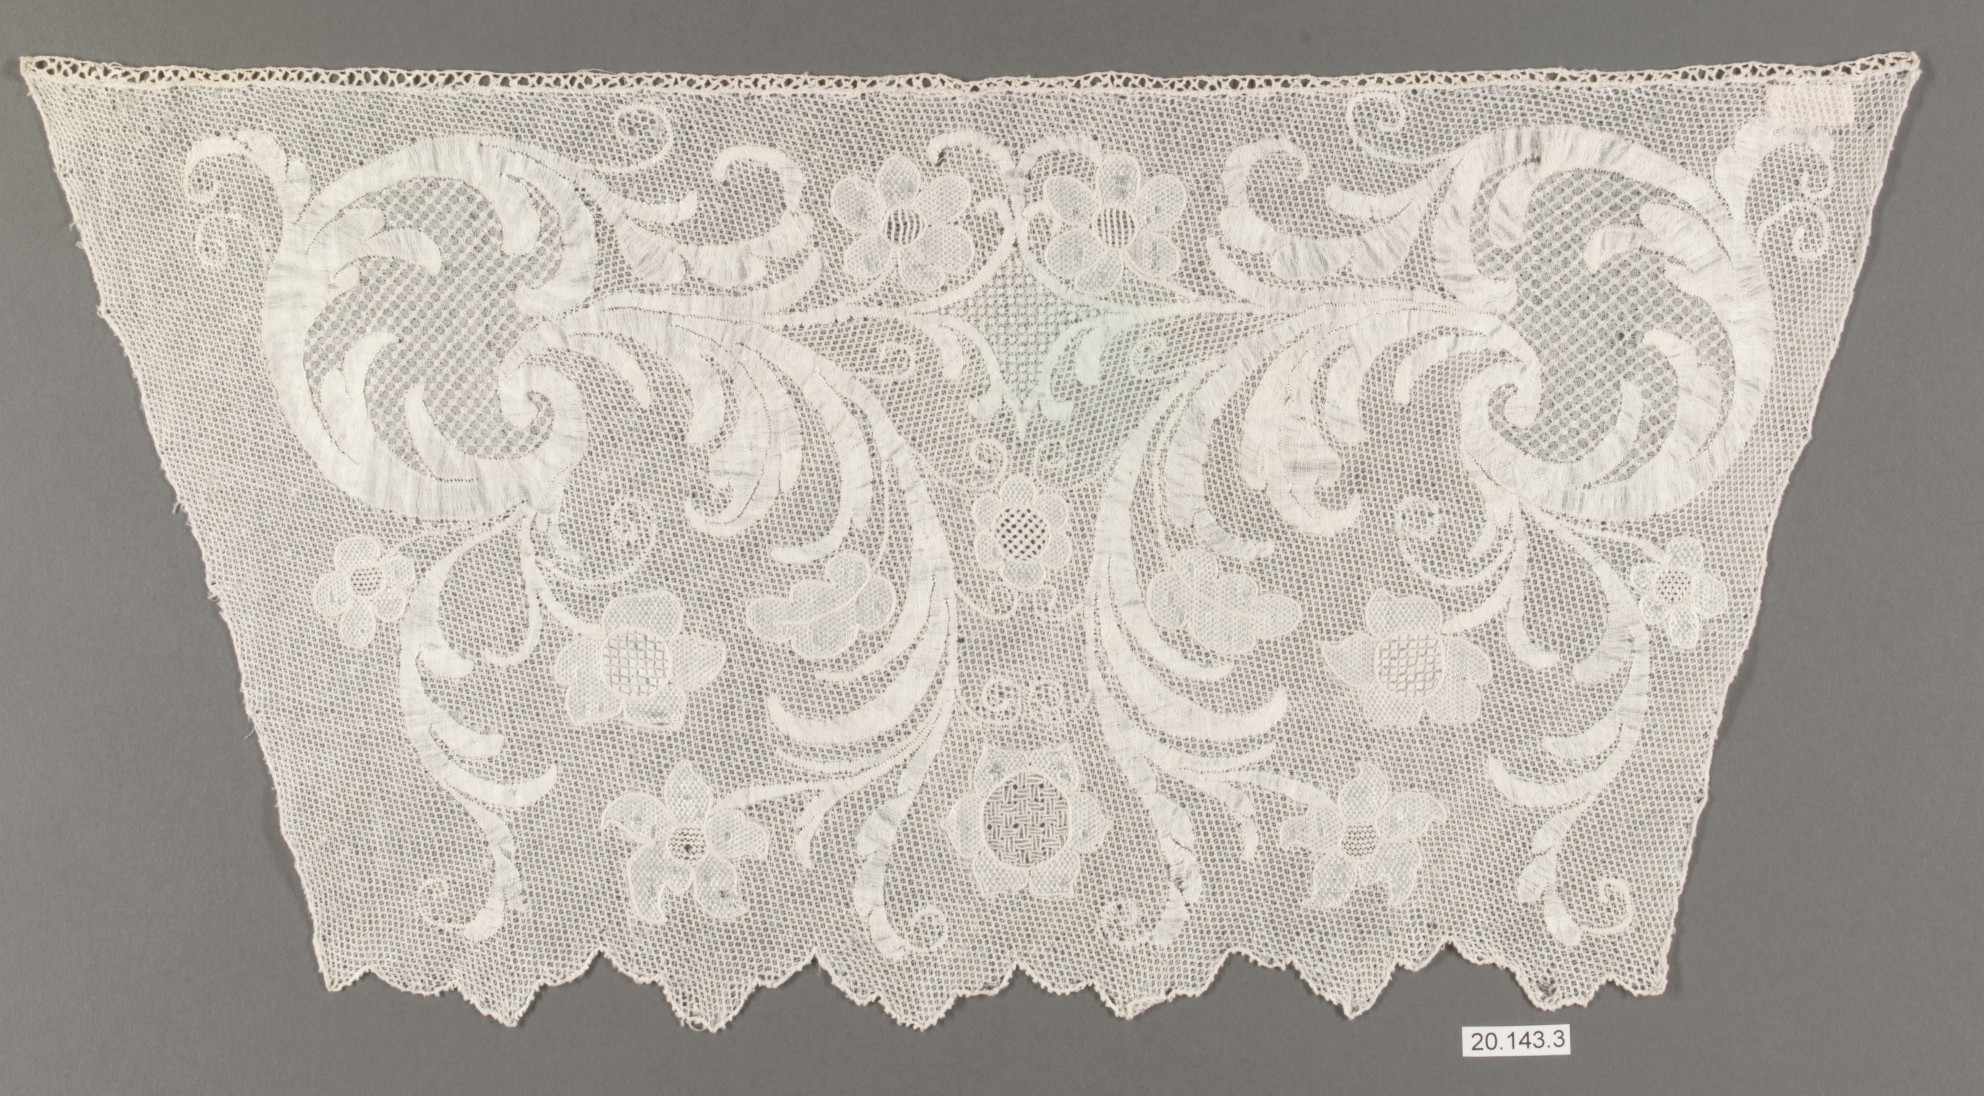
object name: cuff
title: Cuffs (one of a pair)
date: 1701-1800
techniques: embroidery